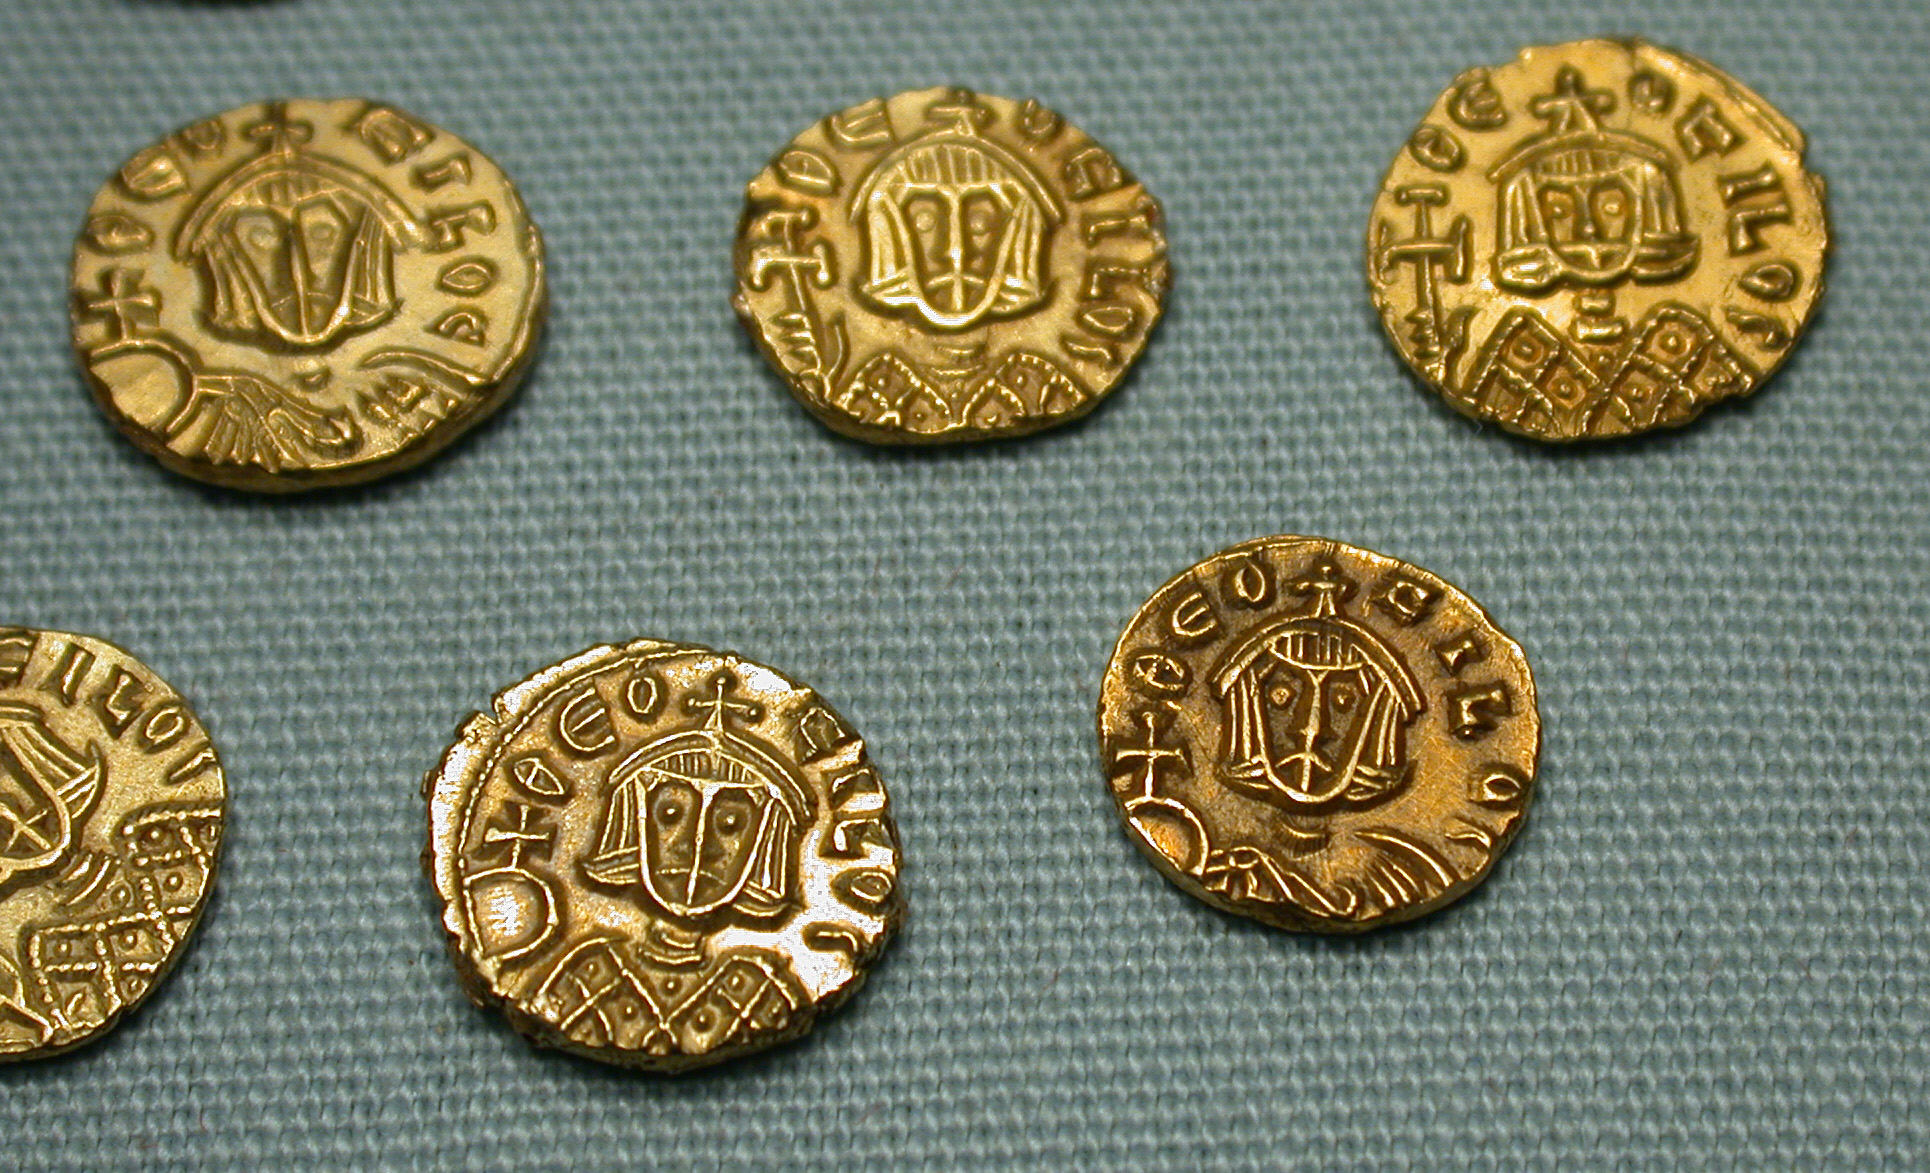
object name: coin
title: Tremissis of Theophilos - 7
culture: byzantine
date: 829-843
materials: gold